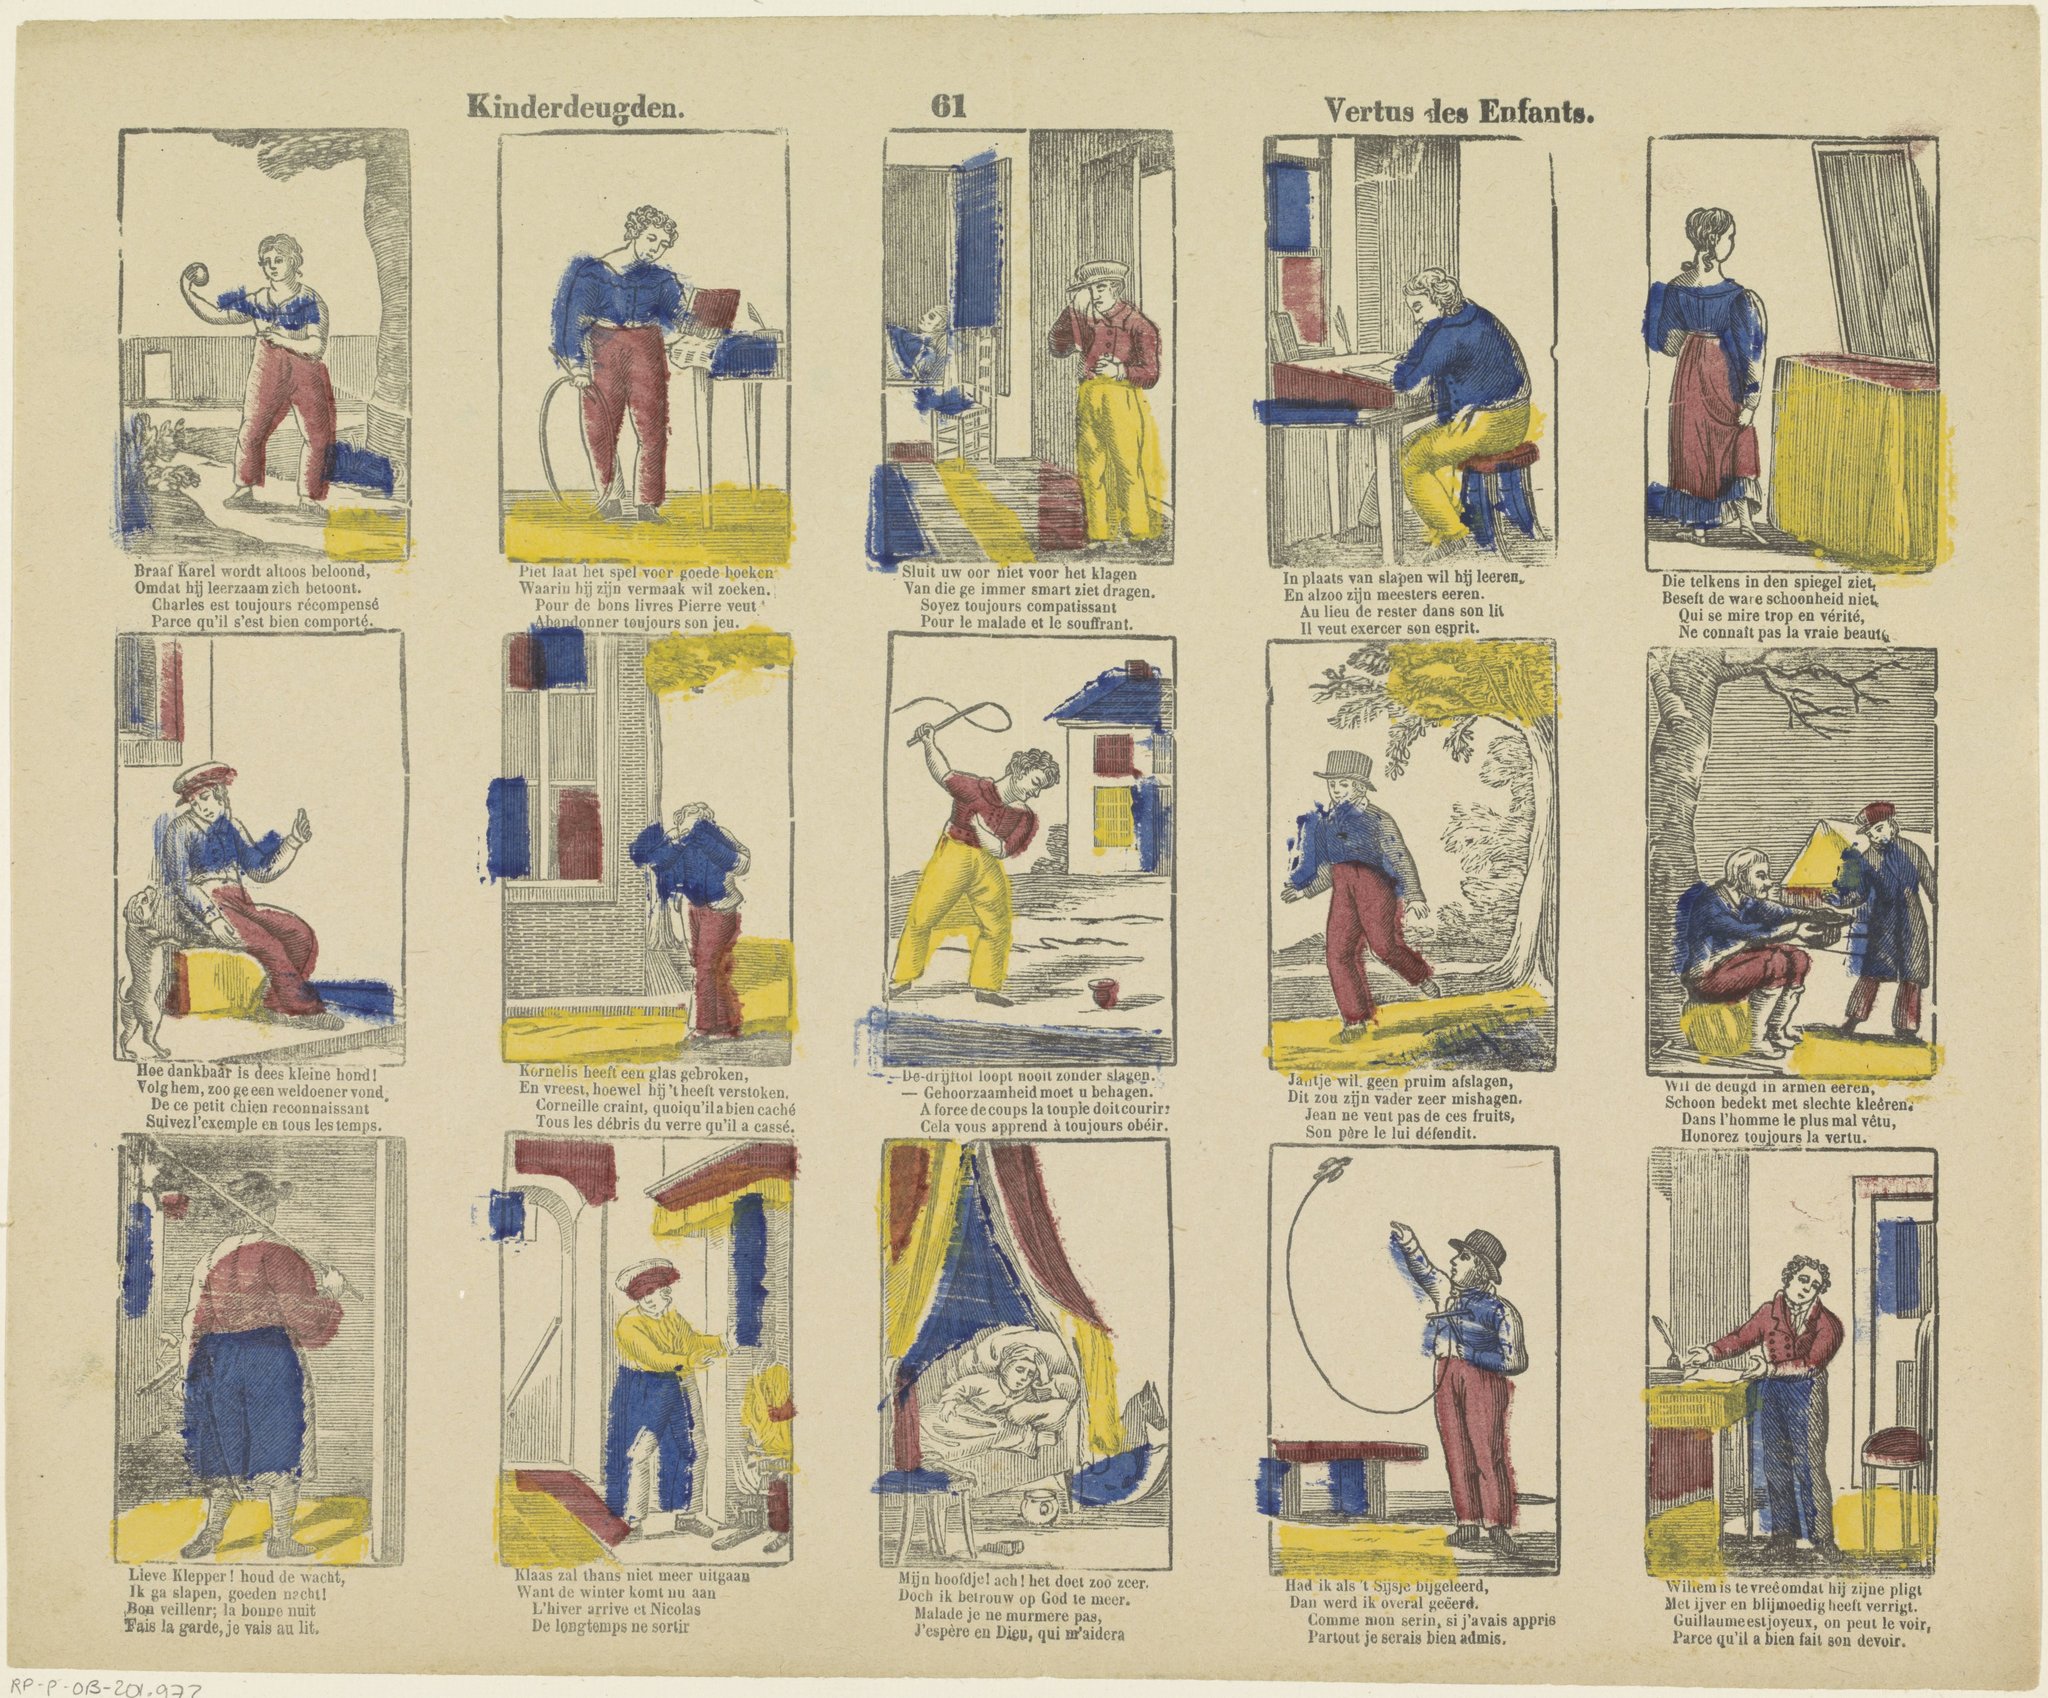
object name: popular print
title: Kinderdeugden / Vertus des Enfants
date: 1800-1833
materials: paper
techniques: colour, letterpress printing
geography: turnhout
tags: children's games and plays, games using special objects (marbles, top, hoop, etc.)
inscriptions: collector's mark: Lugt 2760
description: Blad met 15 voorstellingen van kinderspelen en bezigheden, waaronder lezen en tollen. Onder elke afbeelding een tweeregelig vers in het Nederlands en in het Frans. Genummerd midden boven: 61.